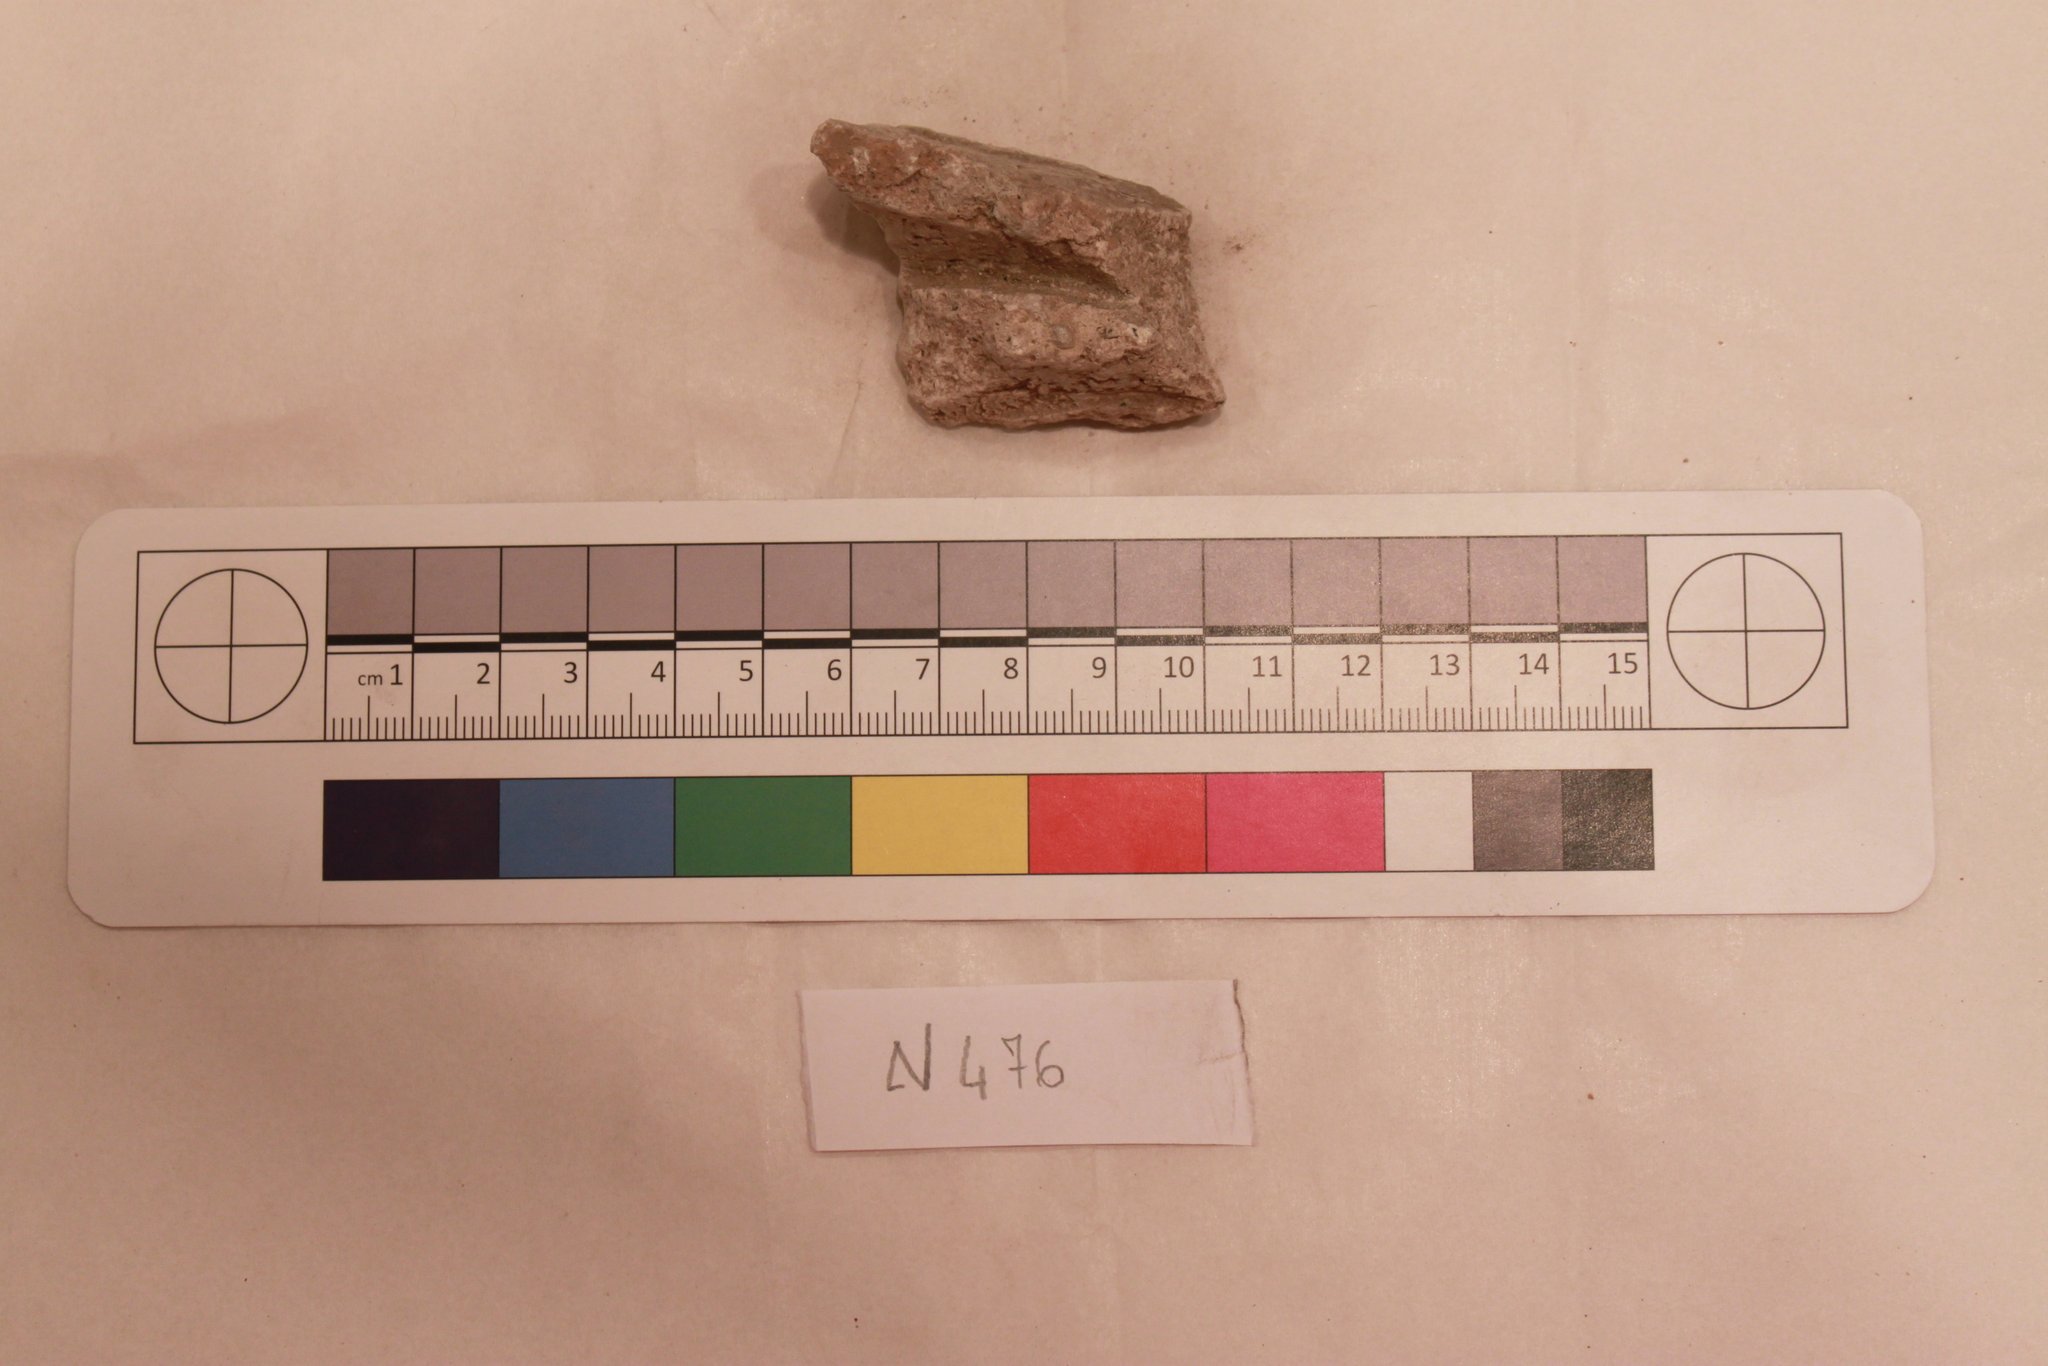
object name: fragment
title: Stucco Fragment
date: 701-1200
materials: plaster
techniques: carving, painting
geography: iran